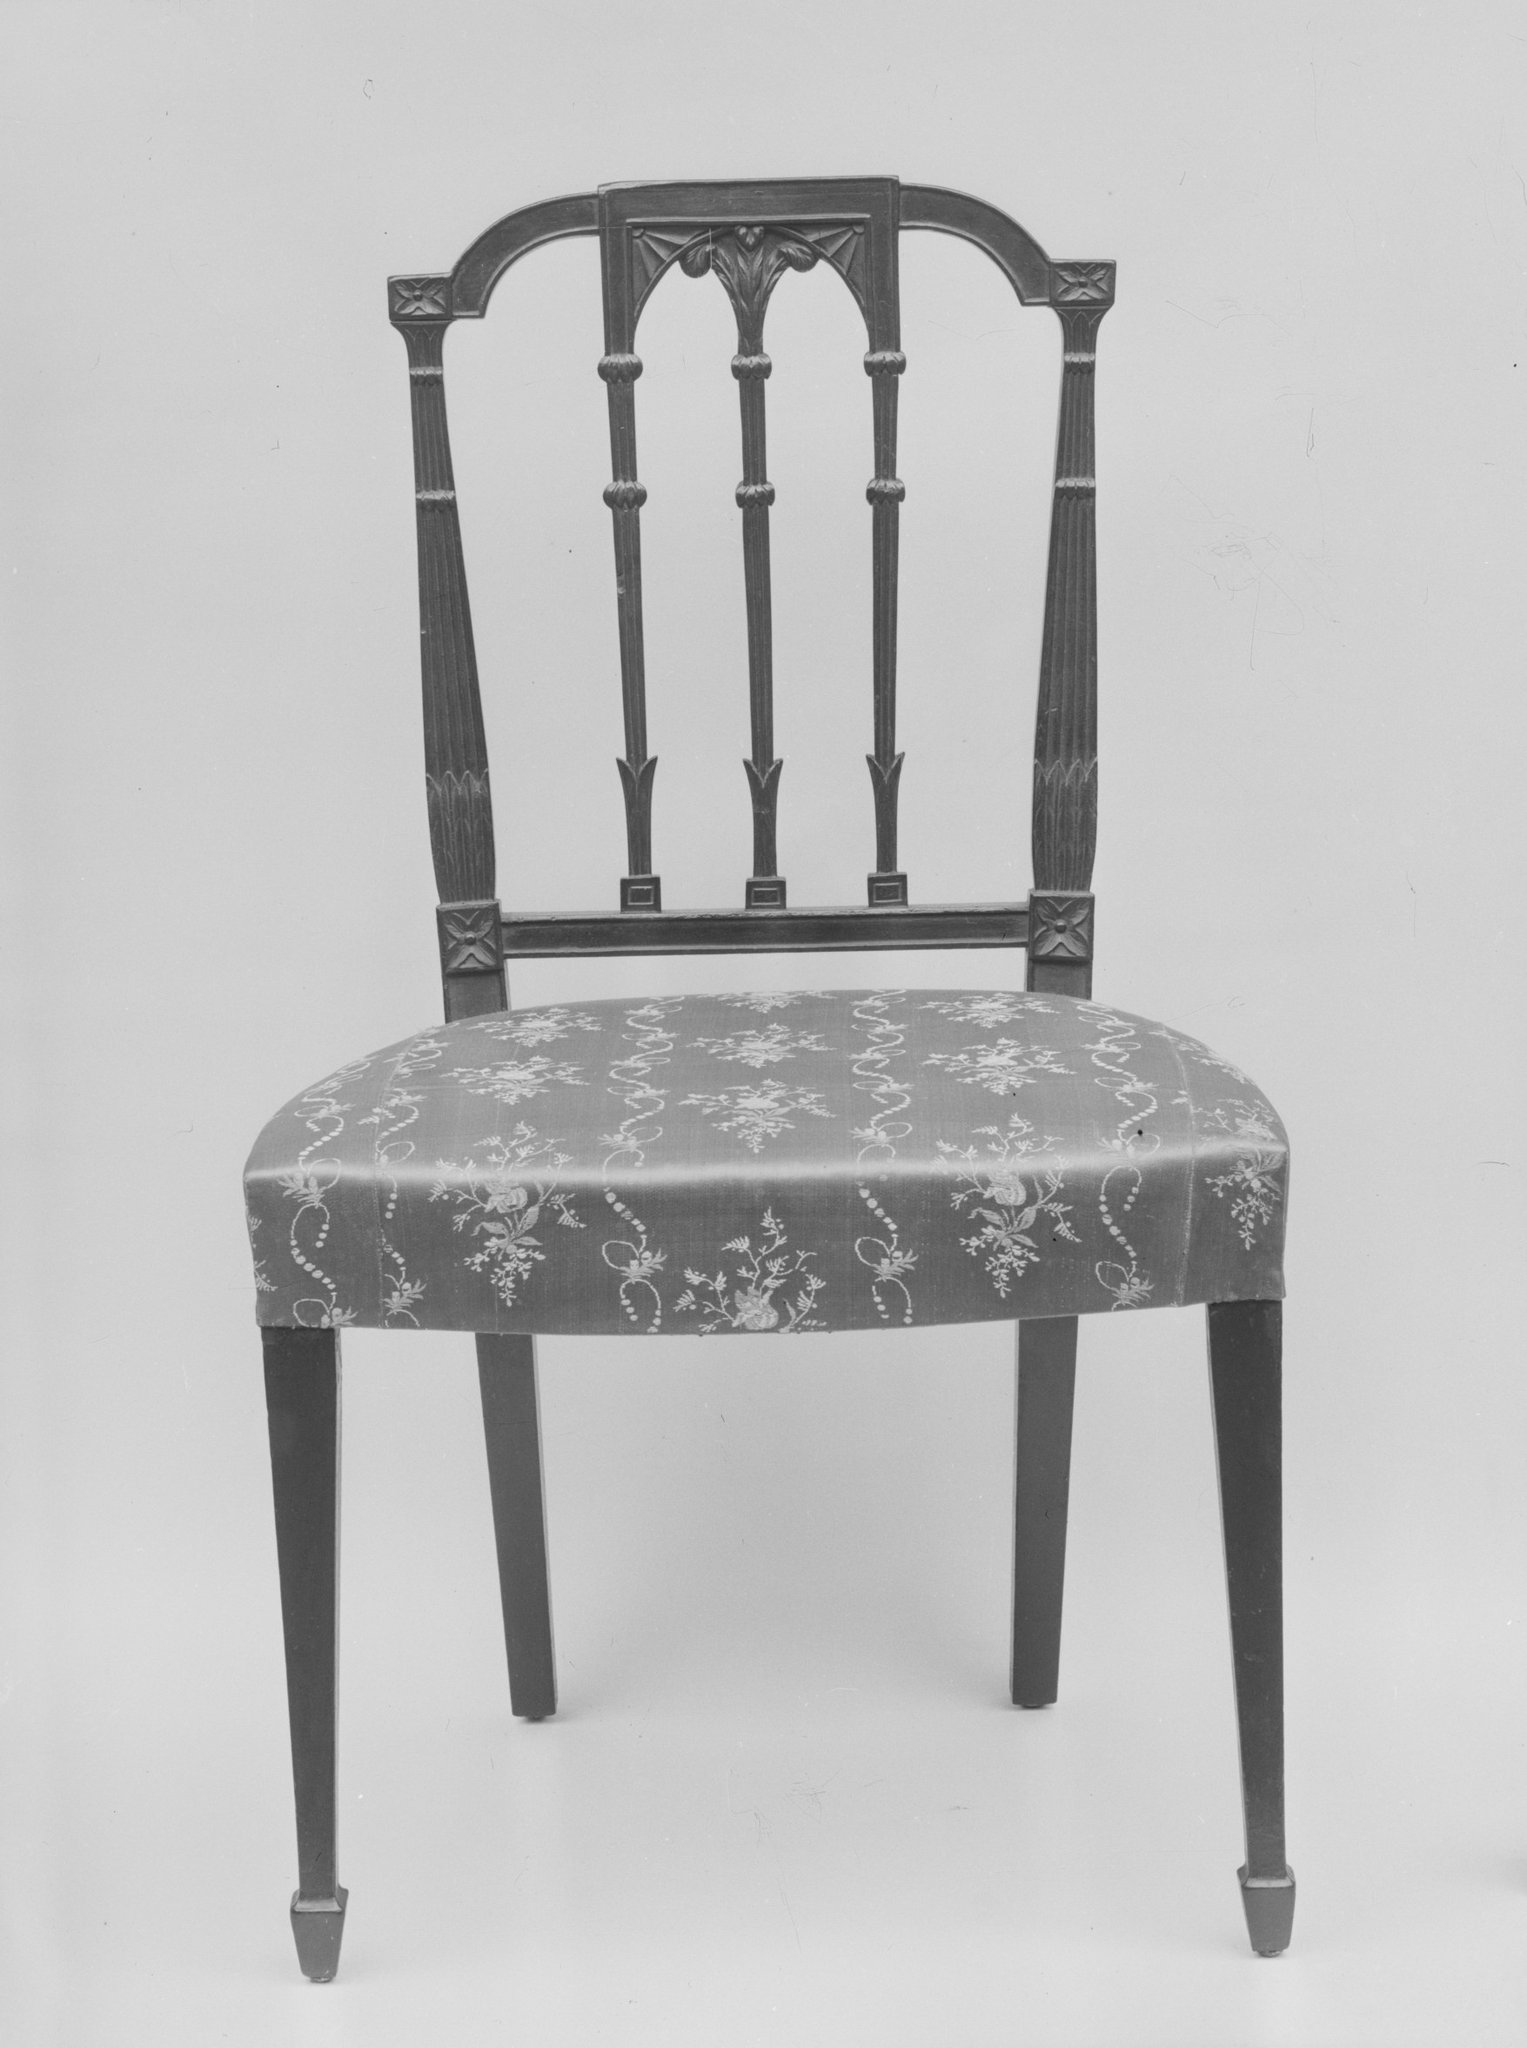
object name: side chair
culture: american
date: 1795-1810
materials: wood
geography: united states